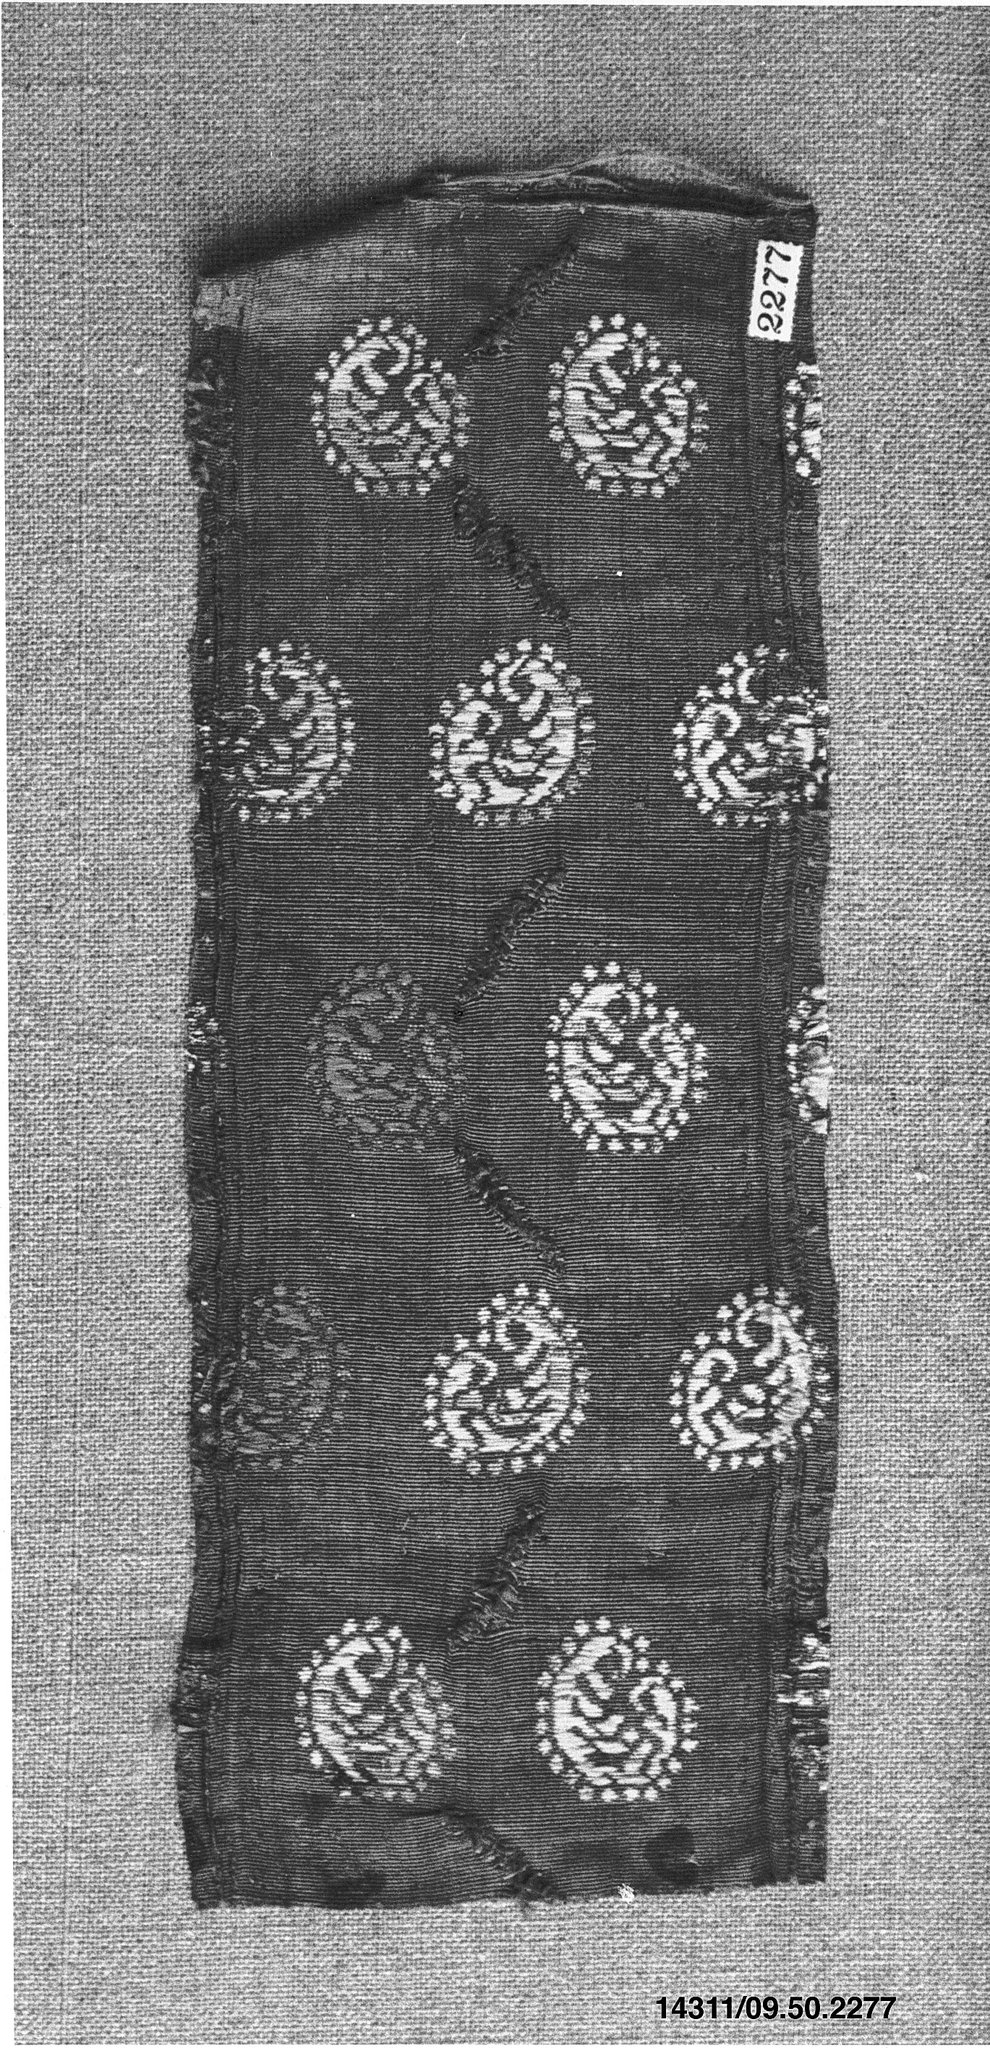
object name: piece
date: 1501-1700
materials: metal thread, silk